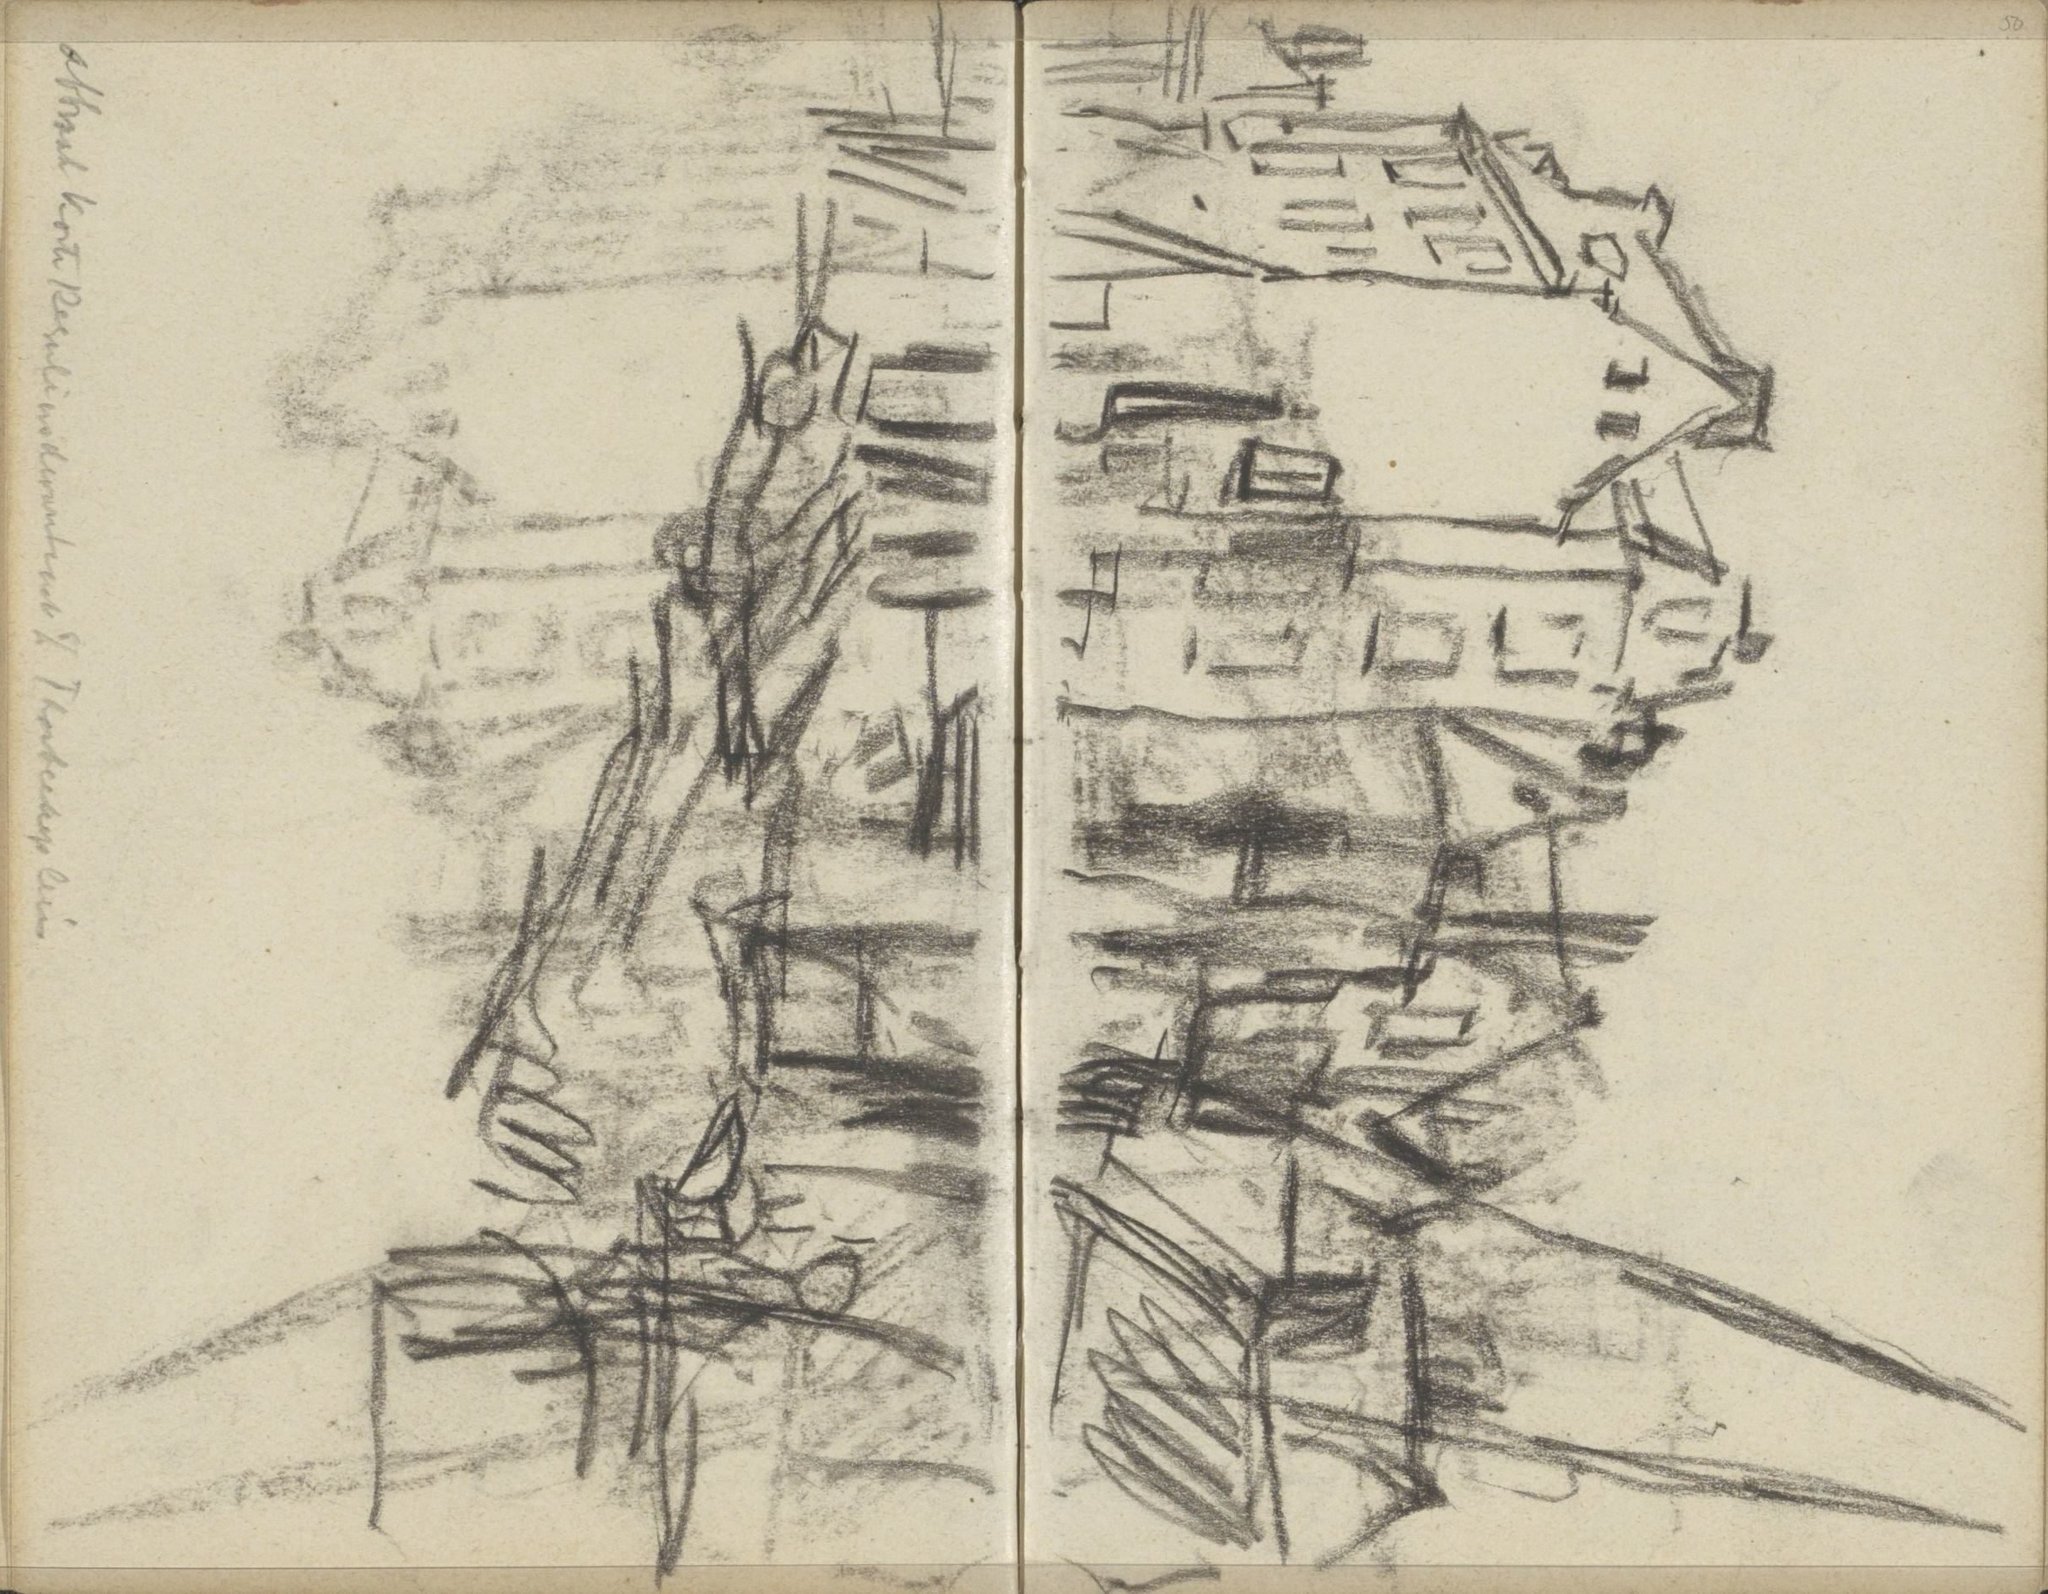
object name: sketchbook leaf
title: Afbraak van de Korte Reguliersdwarsstraat in Amsterdam ter hoogte van het Thorbeckeplein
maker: george hendrik breitner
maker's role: draughtsman, painter, print maker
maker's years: 1857-1923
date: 1910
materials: chalk, paper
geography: amsterdam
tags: demolition of building (+ labourers ~ crafts, industries, agriculture), civic architecture; edifices; dwellings, street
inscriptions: annotation: ‘Afbraak Korte Reguliersdwarsstraat b/h Thorbeckeplein’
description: Pagina 49 en pagina 50 uit een schetsboek met 45 bladen.